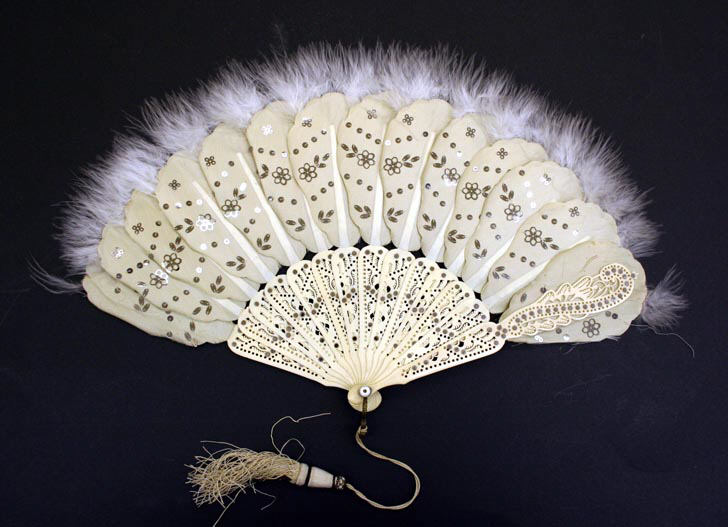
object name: brisé fan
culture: american or european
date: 1860-1870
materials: feather, ivory, metal, silk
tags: flowers